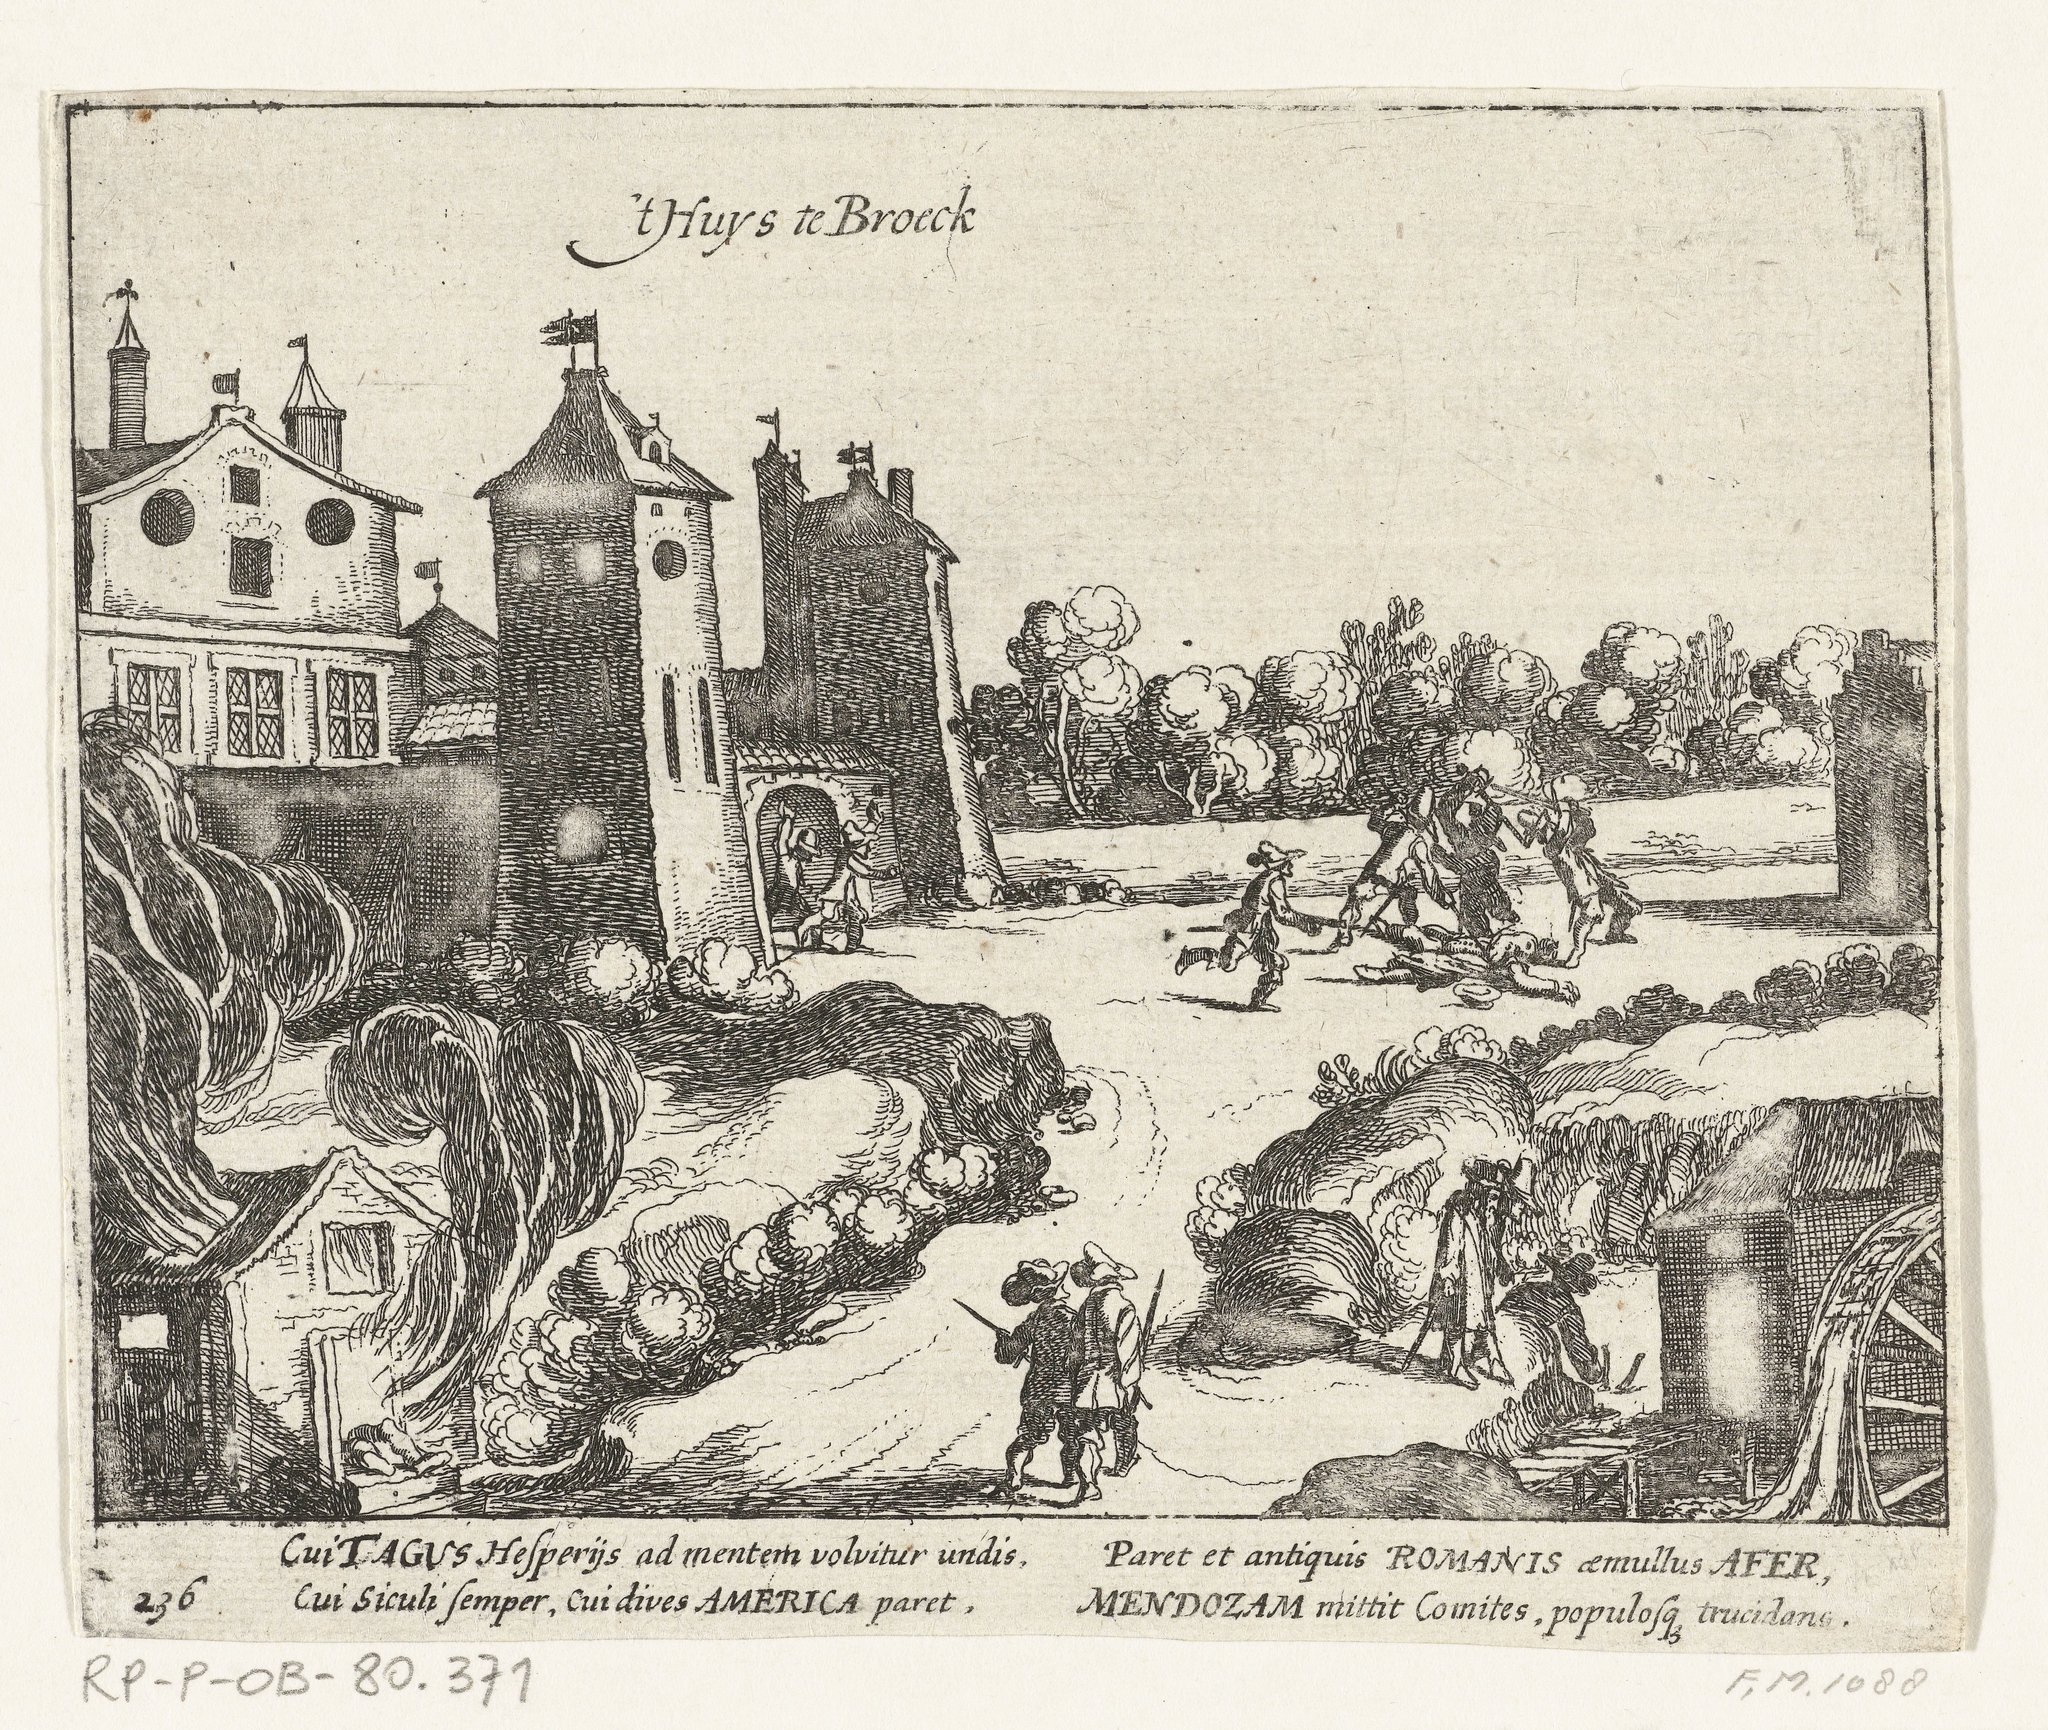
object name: history print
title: 't Huys te Broeck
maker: simon frisius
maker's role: print maker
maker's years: 1570-1628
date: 1613-1615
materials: paper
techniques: etching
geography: northern netherlands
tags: capture of city (after the siege), violent death, being killed; being mishandled and maltreated; seeking death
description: Verovering van het kasteel te Broek aan de Ruhr en de moord op Wirich von Daun, graaf van Falkenstein, door de Spanjaarden onder Francisco de Mendoza begaan op 11 oktober 1598. Met onderschrift van vier regels in het Latijn. Genummerd 236. Bedrukt op de achterzijde met tekst in het Latijn.